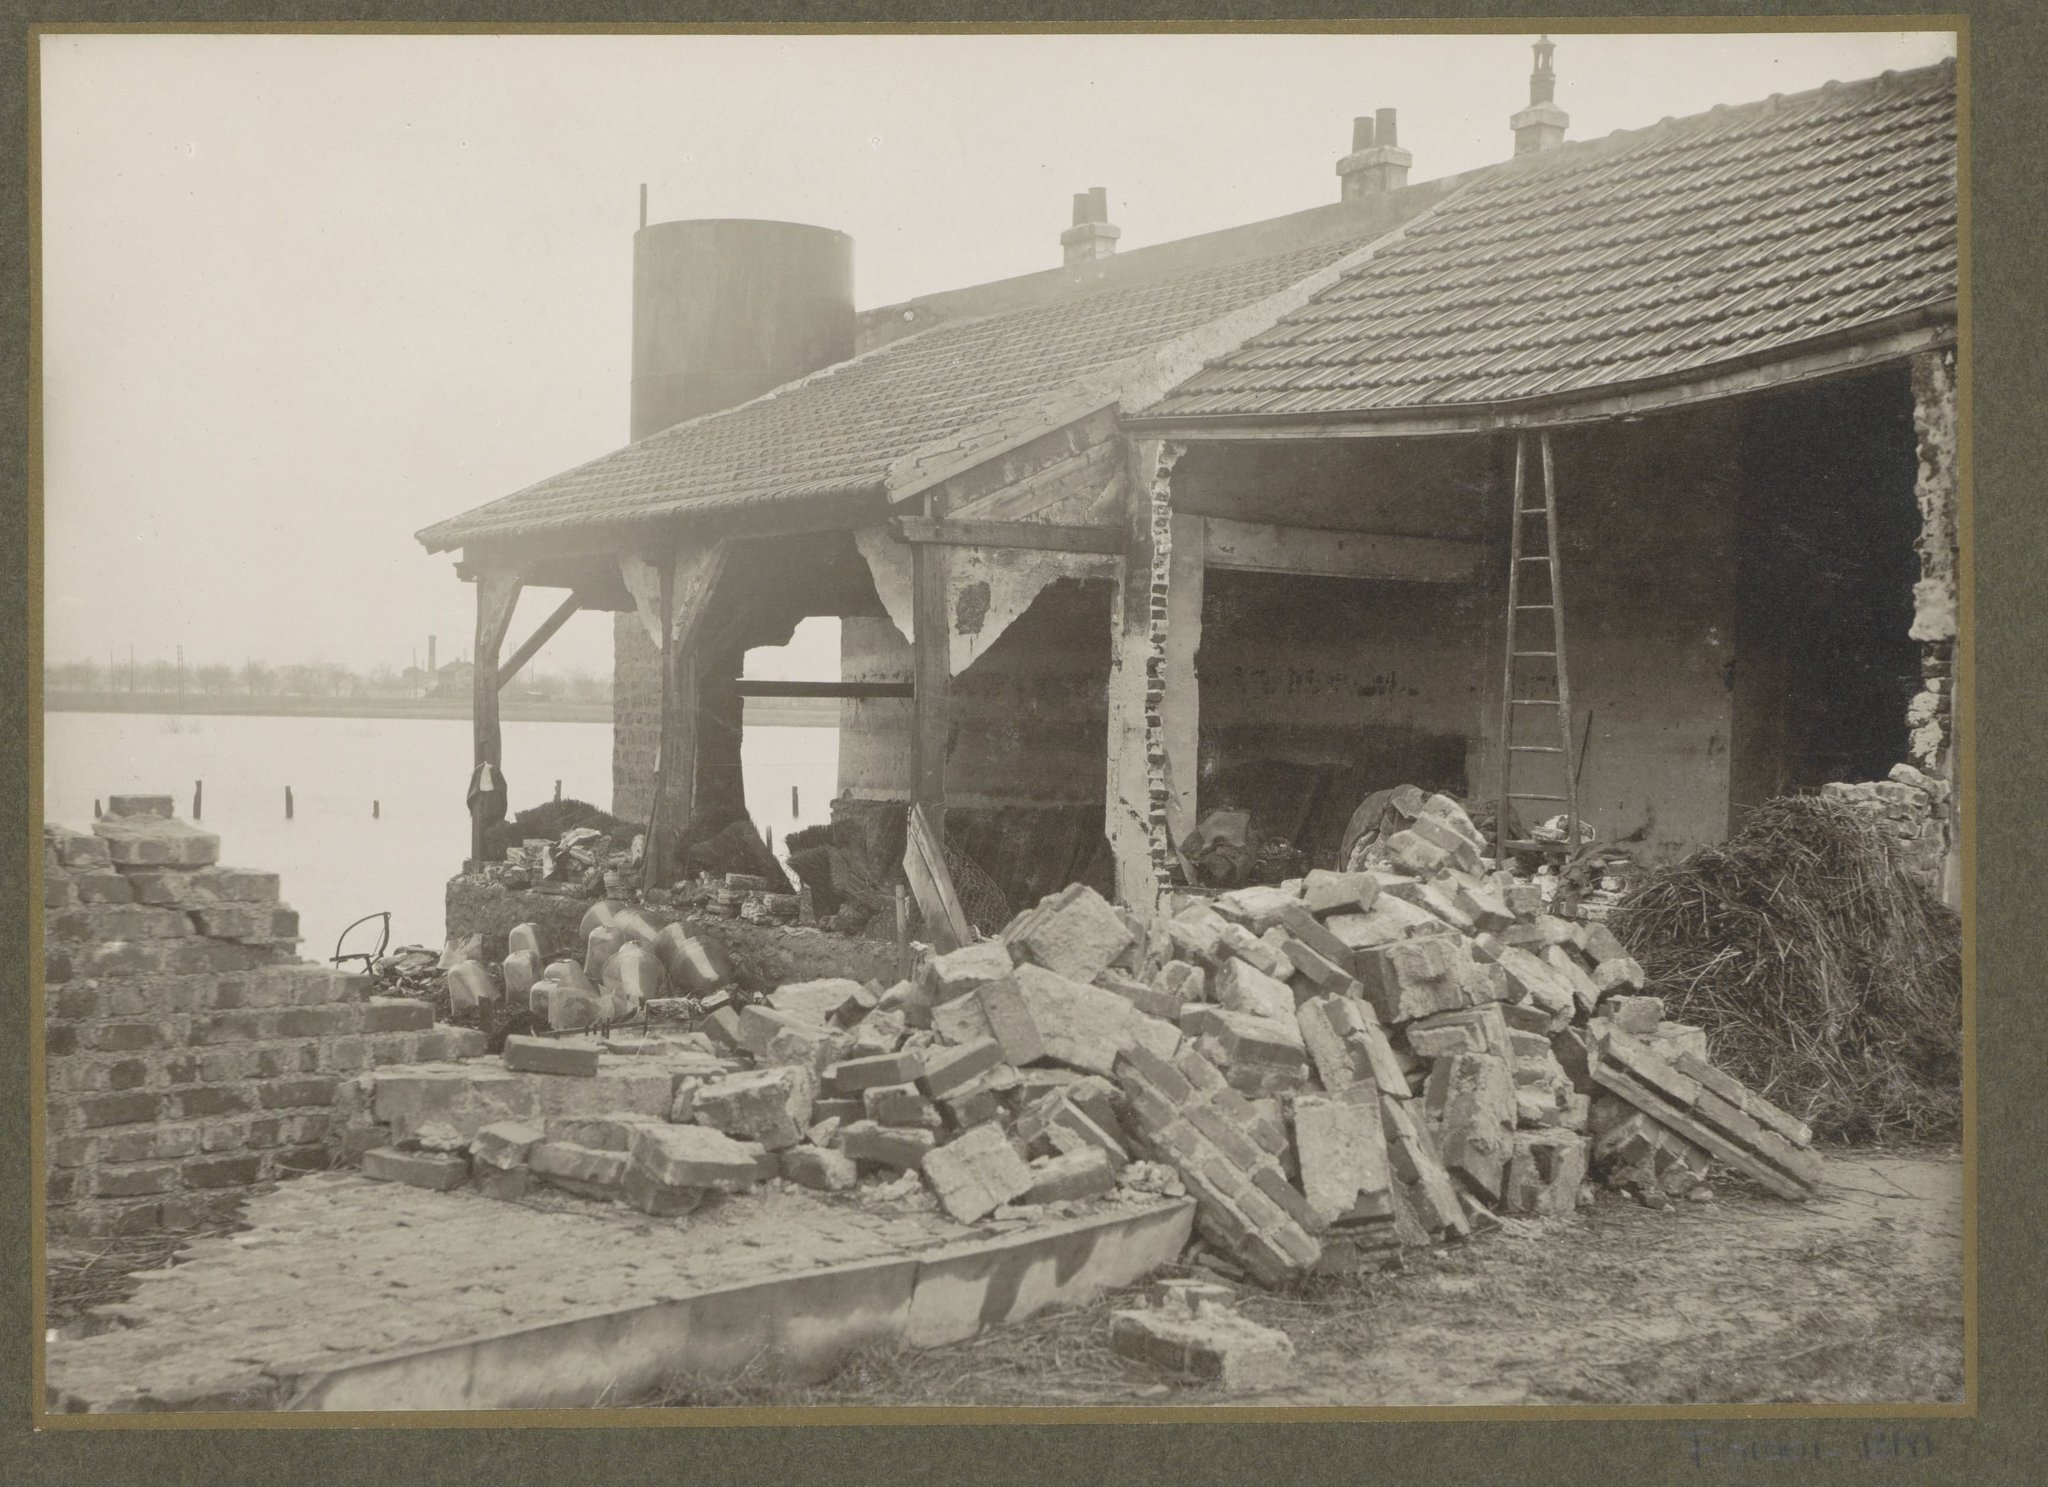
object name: photograph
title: Verwoest gebouw in een overstroomde buitenwijk van Parijs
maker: g. dangereux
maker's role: fotograaf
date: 1901-1910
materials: photographic support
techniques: matte daylight collodion silver print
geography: paris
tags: flood (+ landscape with figures, staffage), child, paris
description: Onderdeel van fotoalbum overstroming Parijs en voorsteden 1910.